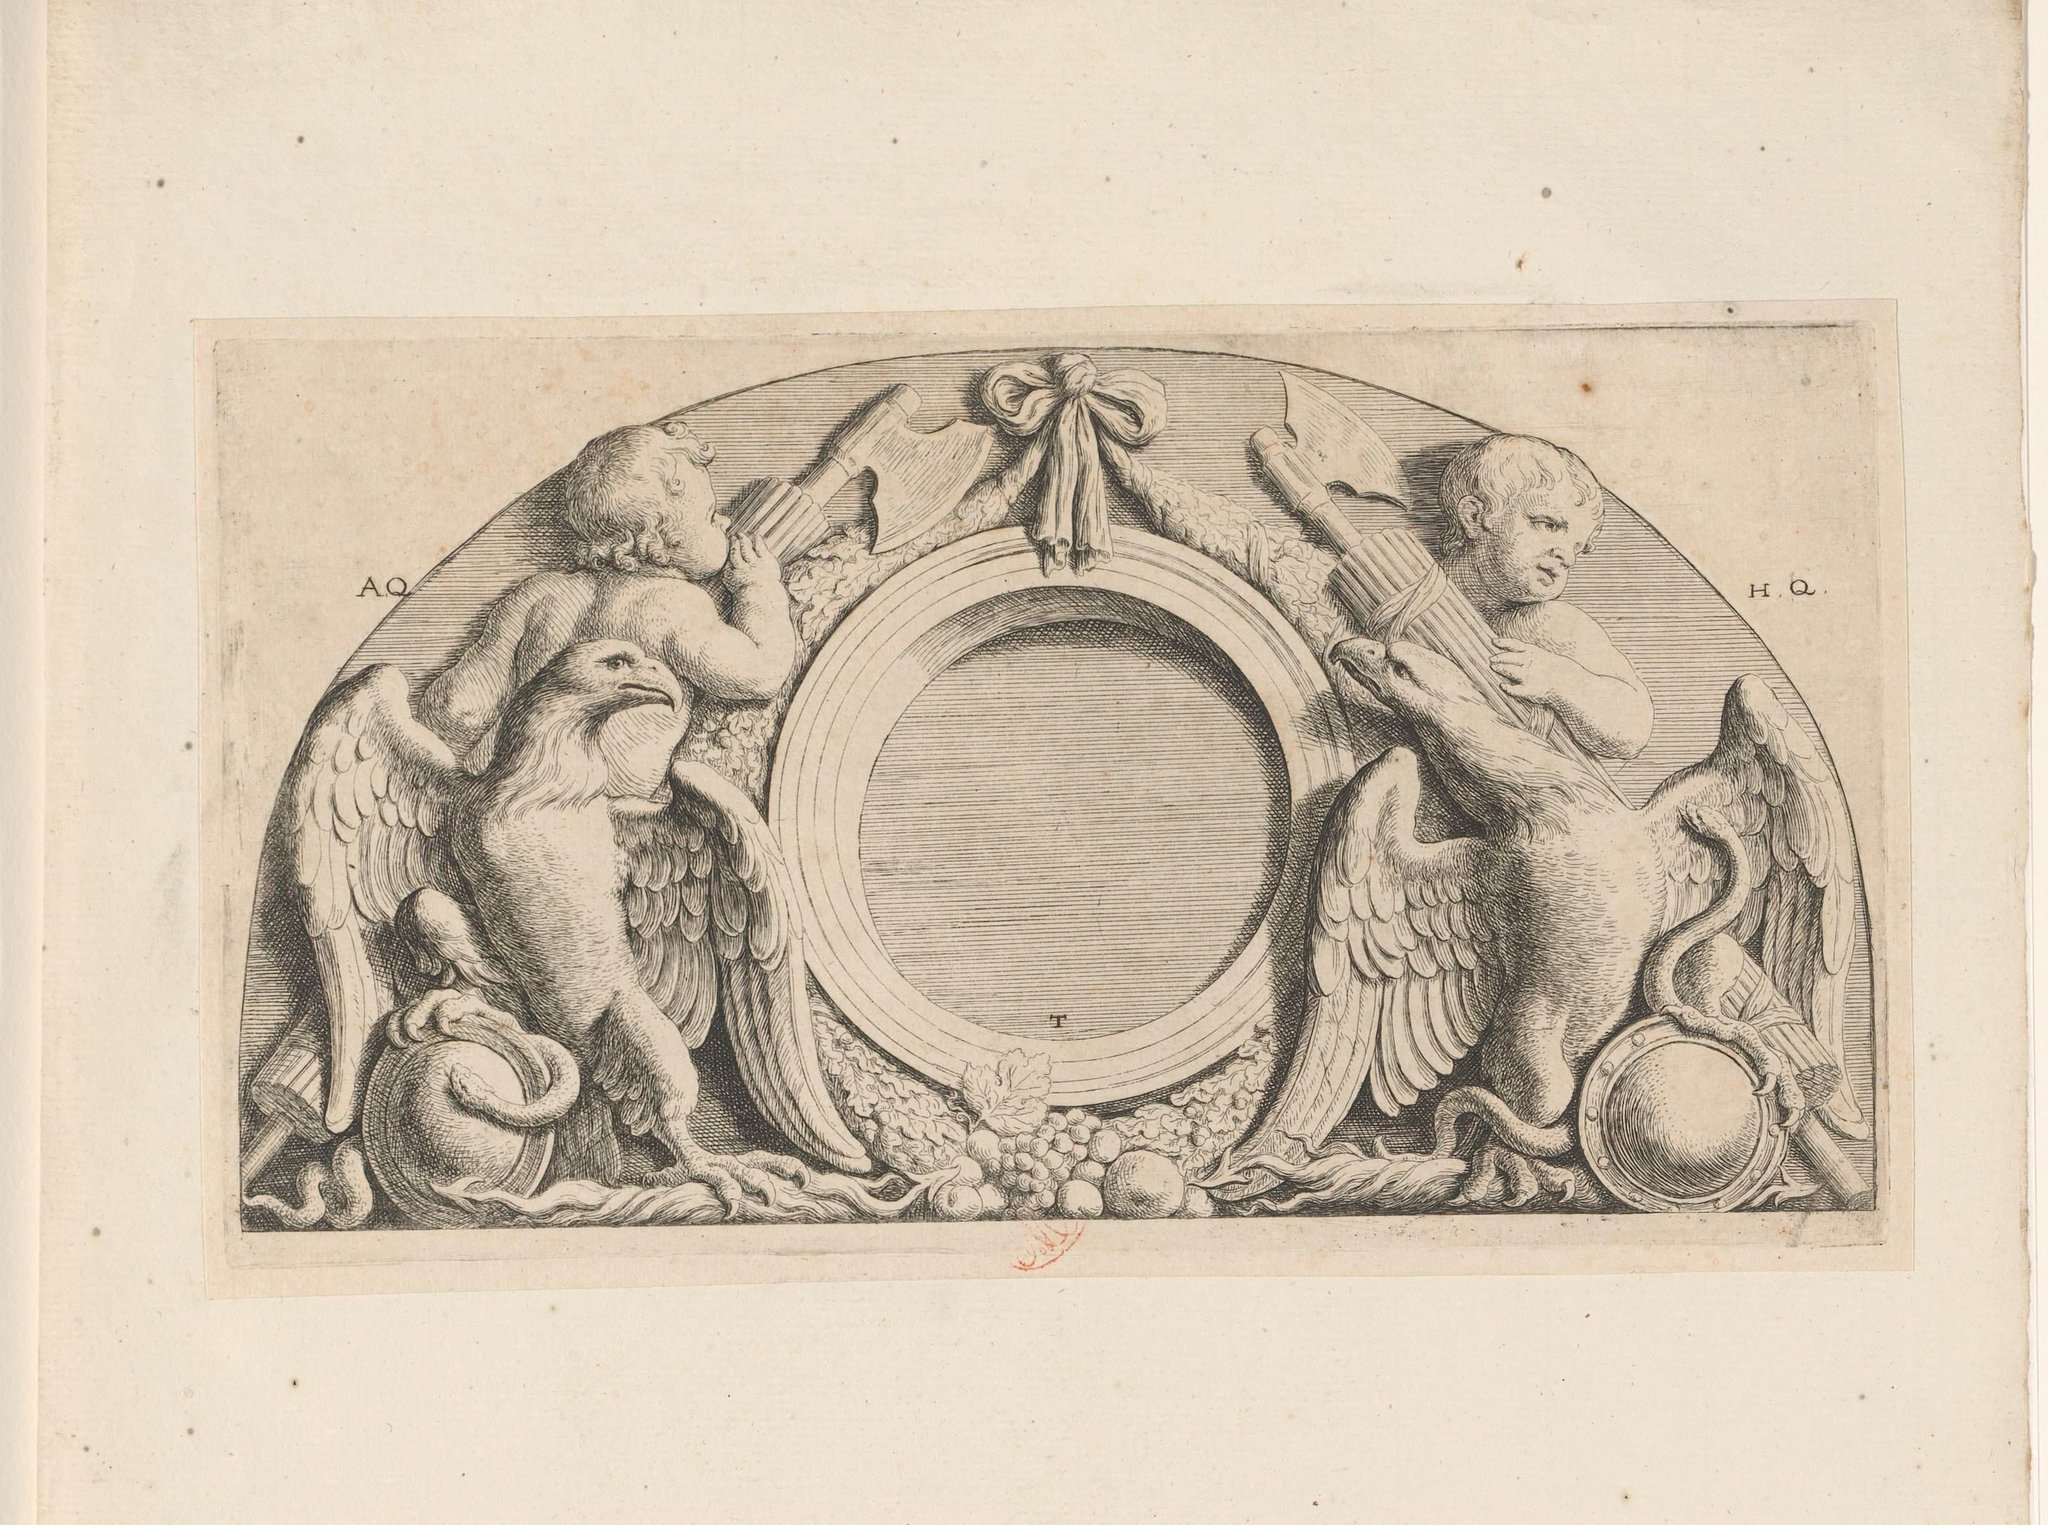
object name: print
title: Lunette met putti, fasces, adelaars en slangen in de Burgerzaal van het Stadhuis op de Dam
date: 1655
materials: paper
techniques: engraving, etching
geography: amsterdam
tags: predatory birds: eagle, mirror, cupids: 'amores', 'amoretti', 'putti', attributes of jupiter: thunderbolt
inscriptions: collector's mark: Lugt 195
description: Prent gebruikt in: Prima pars. Praecipuarum effigierum ac ornamentorum, amplissimae Curiae Amstelrodamensis (…) / Het eerste deel. Van de voornaemste Statuen ende Ciraten, vant konstijck Stadhuys van Amstelredam, tmeeste in marmer gemaeckt, door Artus Quellinus, Beelthouwer der voorseyde Stadt / La Premier Partie. De plusieurs Figures et ornements, de la Maison de Ville d'Amsterdam (…). Amsterdam: Artus Quellinus (I), 1655. Zie RP-P-AO-22-1-1 voor bijhorende titelpagina. Zie RP-P-AO-22-1-2 voor bijhorend register. Zie RP-P-AO-22-1A, RP-P-AO-22-1B, RP-P-AO-22-1C, RP-P-AO-22-1D-1, RP-P-AO-22-1D-2, RP-P-AO-22-1E, RP-P-AO-22-1F, RP-P-AO-22-1G, RP-P-AO-22-1H, RP-P-AO-22-1I, RP-P-AO-22-1K-1, RP-P-AO-22-1K-2, RP-P-AO-22-1K-3, RP-P-AO-22-1K-4, RP-P-AO-22-1K-5, RP-P-AO-22-1L-1, RP-P-AO-22-1L-2, RP-P-AO-22-1M-1, RP-P-AO-22-1M-2, RP-P-AO-22-1N-1, RP-P-AO-22-1N-2, RP-P-AO-22-1N-3, RP-P-AO-22-1N-4, RP-P-AO-22-1N-5, RP-P-AO-22-1O-1, RP-P-AO-22-1O-2, RP-P-AO-22-1O-3, RP-P-AO-22-1O-4, RP-P-AO-22-1P-1, RP-P-AO-22-1P-2, RP-P-AO-22-1P-3, RP-P-AO-22-1P-4, RP-P-AO-22-1Q-1, RP-P-AO-22-1Q-2, RP-P-AO-22-1Q-3, RP-P-AO-22-1Q-4, RP-P-AO-22-1R-1, RP-P-AO-22-1R-2, RP-P-AO-22-1R-3, RP-P-AO-22-1R-4, RP-P-AO-22-1R-5, RP-P-AO-22-1S-1, RP-P-AO-22-1S-2, RP-P-AO-22-1S-3, RP-P-AO-22-1S-4, RP-P-AO-22-1S-5 en RP-P-AO-22-1T-2 voor andere prenten uit deze publicatie. Zelfde staat van prent ook gebruikt in: Prima pars. Praecipuarum effigierum ac ornamentorum, amplissimae Curiae Amstelrodamensis (…) / Het eerste deel. Van de voornaemste Statuen ende Ciraten, vant konstijck Stadhuys van Amstelredam, tmeeste in marmer gemaeckt, door Artus Quellinus, Beelthouwer der voorseyde Stadt / La Premier Partie. De plusieurs Figures et ornements, de la Maison de Ville d'Amsterdam (…). Amsterdam: Frederik de Wit, 1665. Latere staat van prent ook gebruikt in: Architecture peinture et sculpture de la Maison de Ville d'Amsterdam, representee en CIX. figures en taille-douce (…). Amsterdam: David Mortier, 1719. En in: Architecture peinture et sculpture de la Maison de Ville d'Amsterdam, representee en CIX. figures en taille-douce (…). Amsterdam: Gerard Valck, 1719. En in: Bouw schilder en beeldhouwkonst, van het Stadhuis te Amsteldam, vertoont in CIX figuuren (…). Amsterdam: Covens & Mortier & Covens Jr., s.a. (1774-1783).